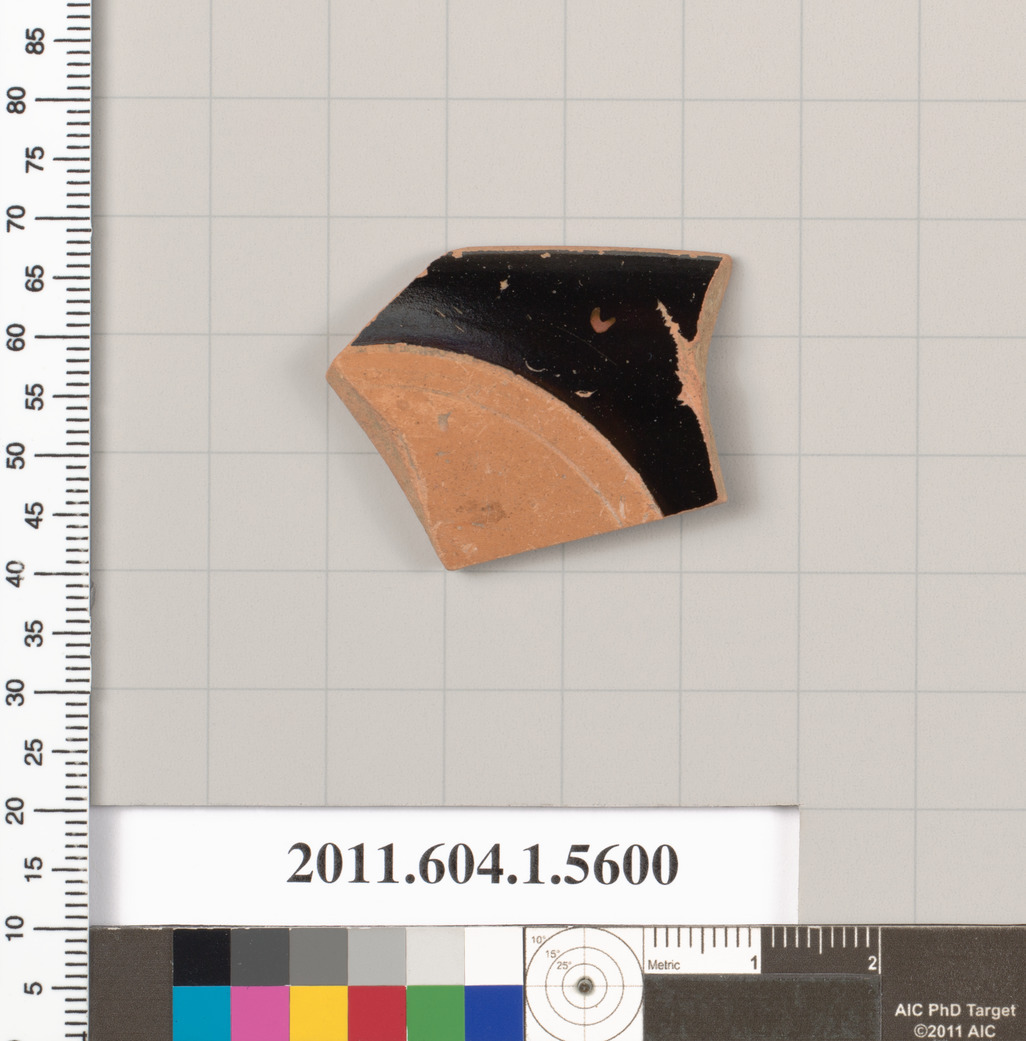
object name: kylix fragment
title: Terracotta rim fragment of a kylix (drinking cup)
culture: greek, attic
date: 520-490 BCE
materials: terracotta